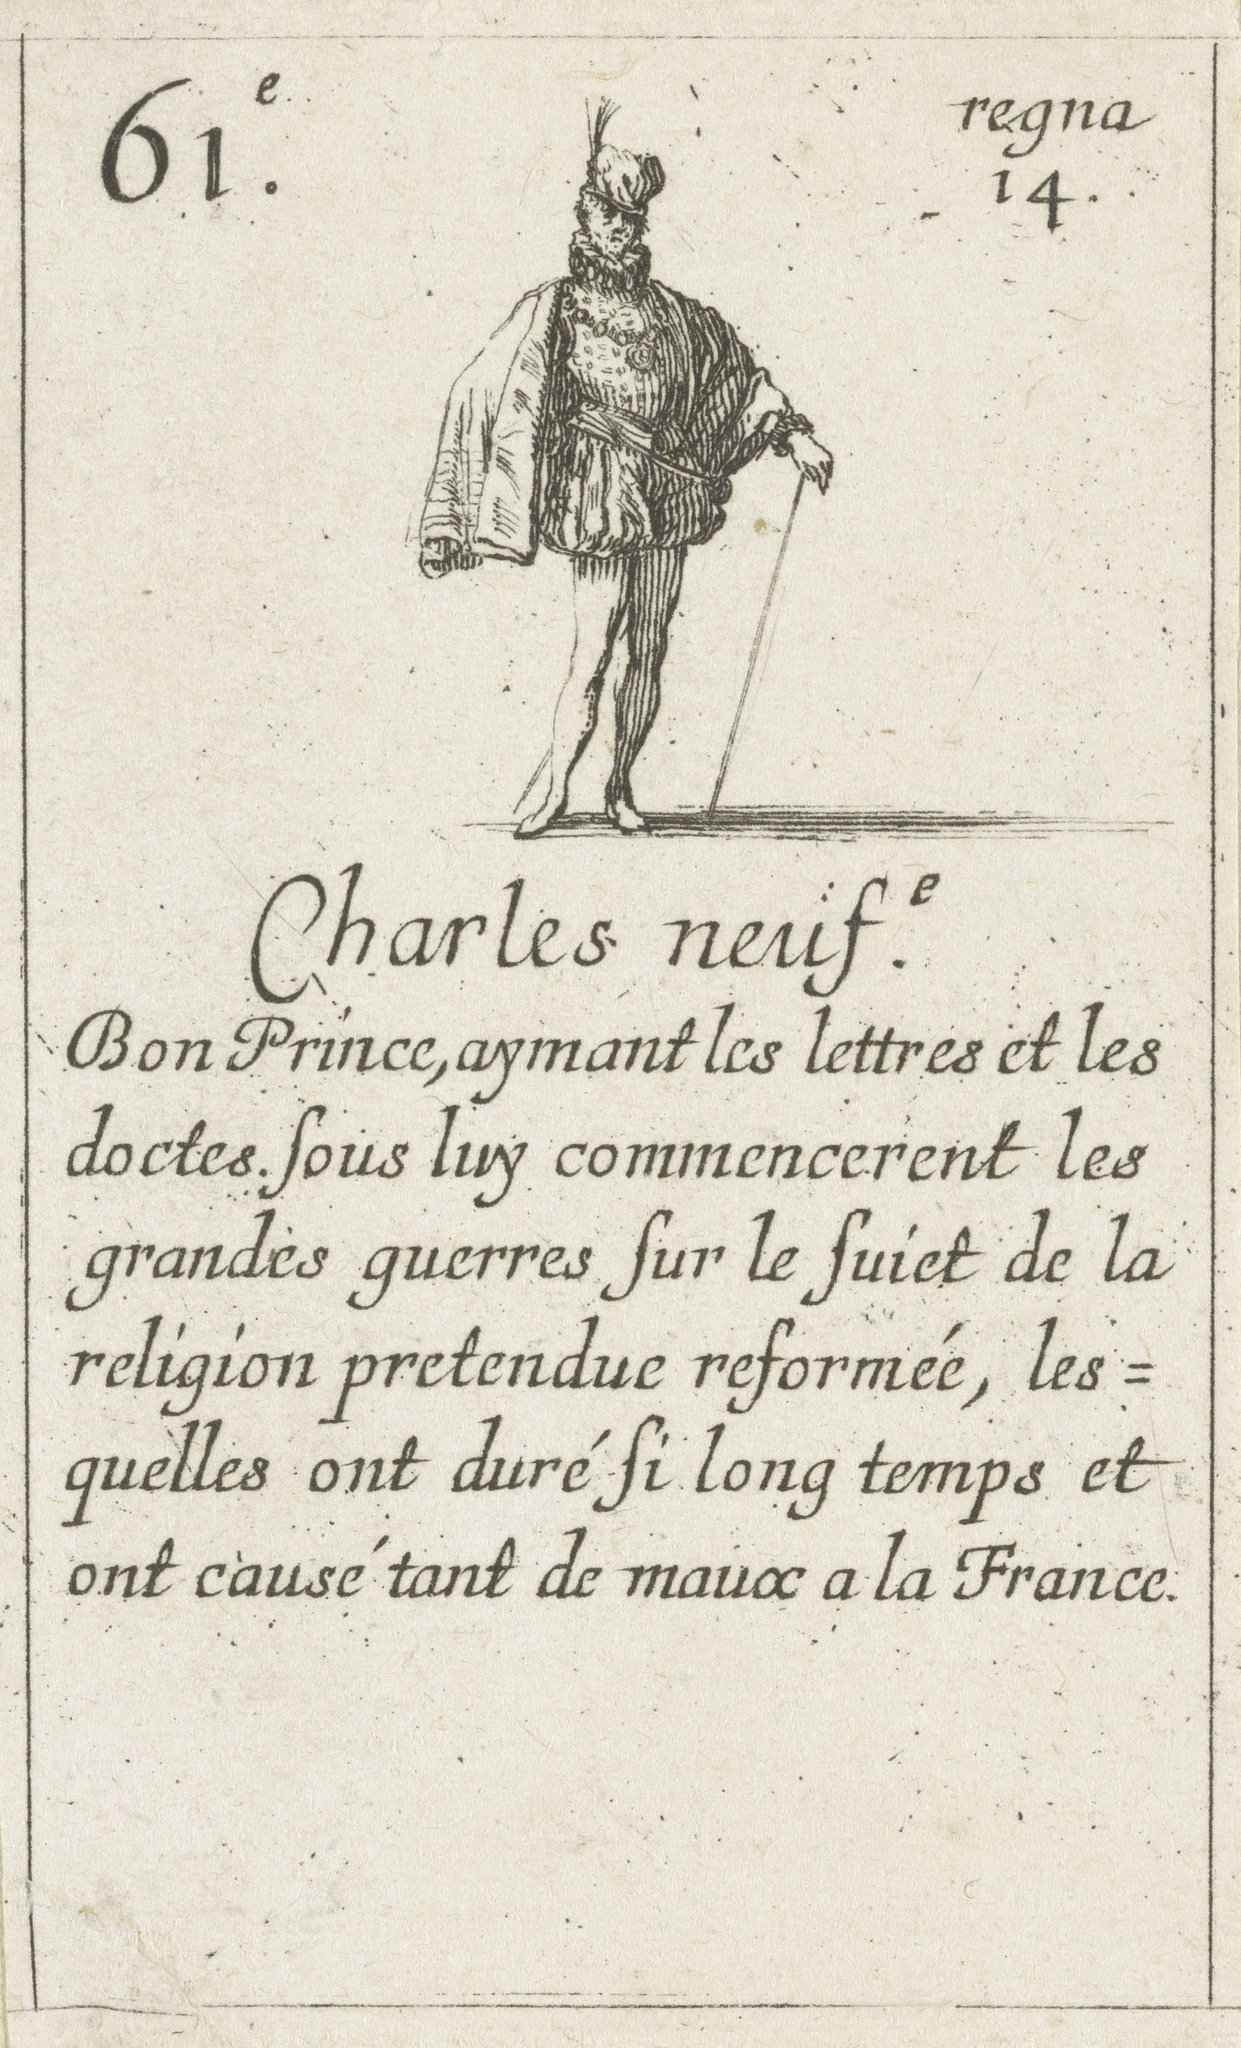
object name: print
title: Cartes des rois de France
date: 1620-1664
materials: paper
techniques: etching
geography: paris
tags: karel ix (koning van frankrijk), ruler, sovereign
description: Deze prent maakt deel uit van een kaartspel met 39 kaarten met voorstellingen van Franse koningen. De serie is uitgedacht door Jean Desmarests de Saint-Sorlin in opdracht van Kardinaal Mazarin. Het kaartspel werd gemaakt voor de jonge Lodewijk XIV, samen met het Jeu des Fables, Jeu des Reynes Renommées en Jeu de la géographie.